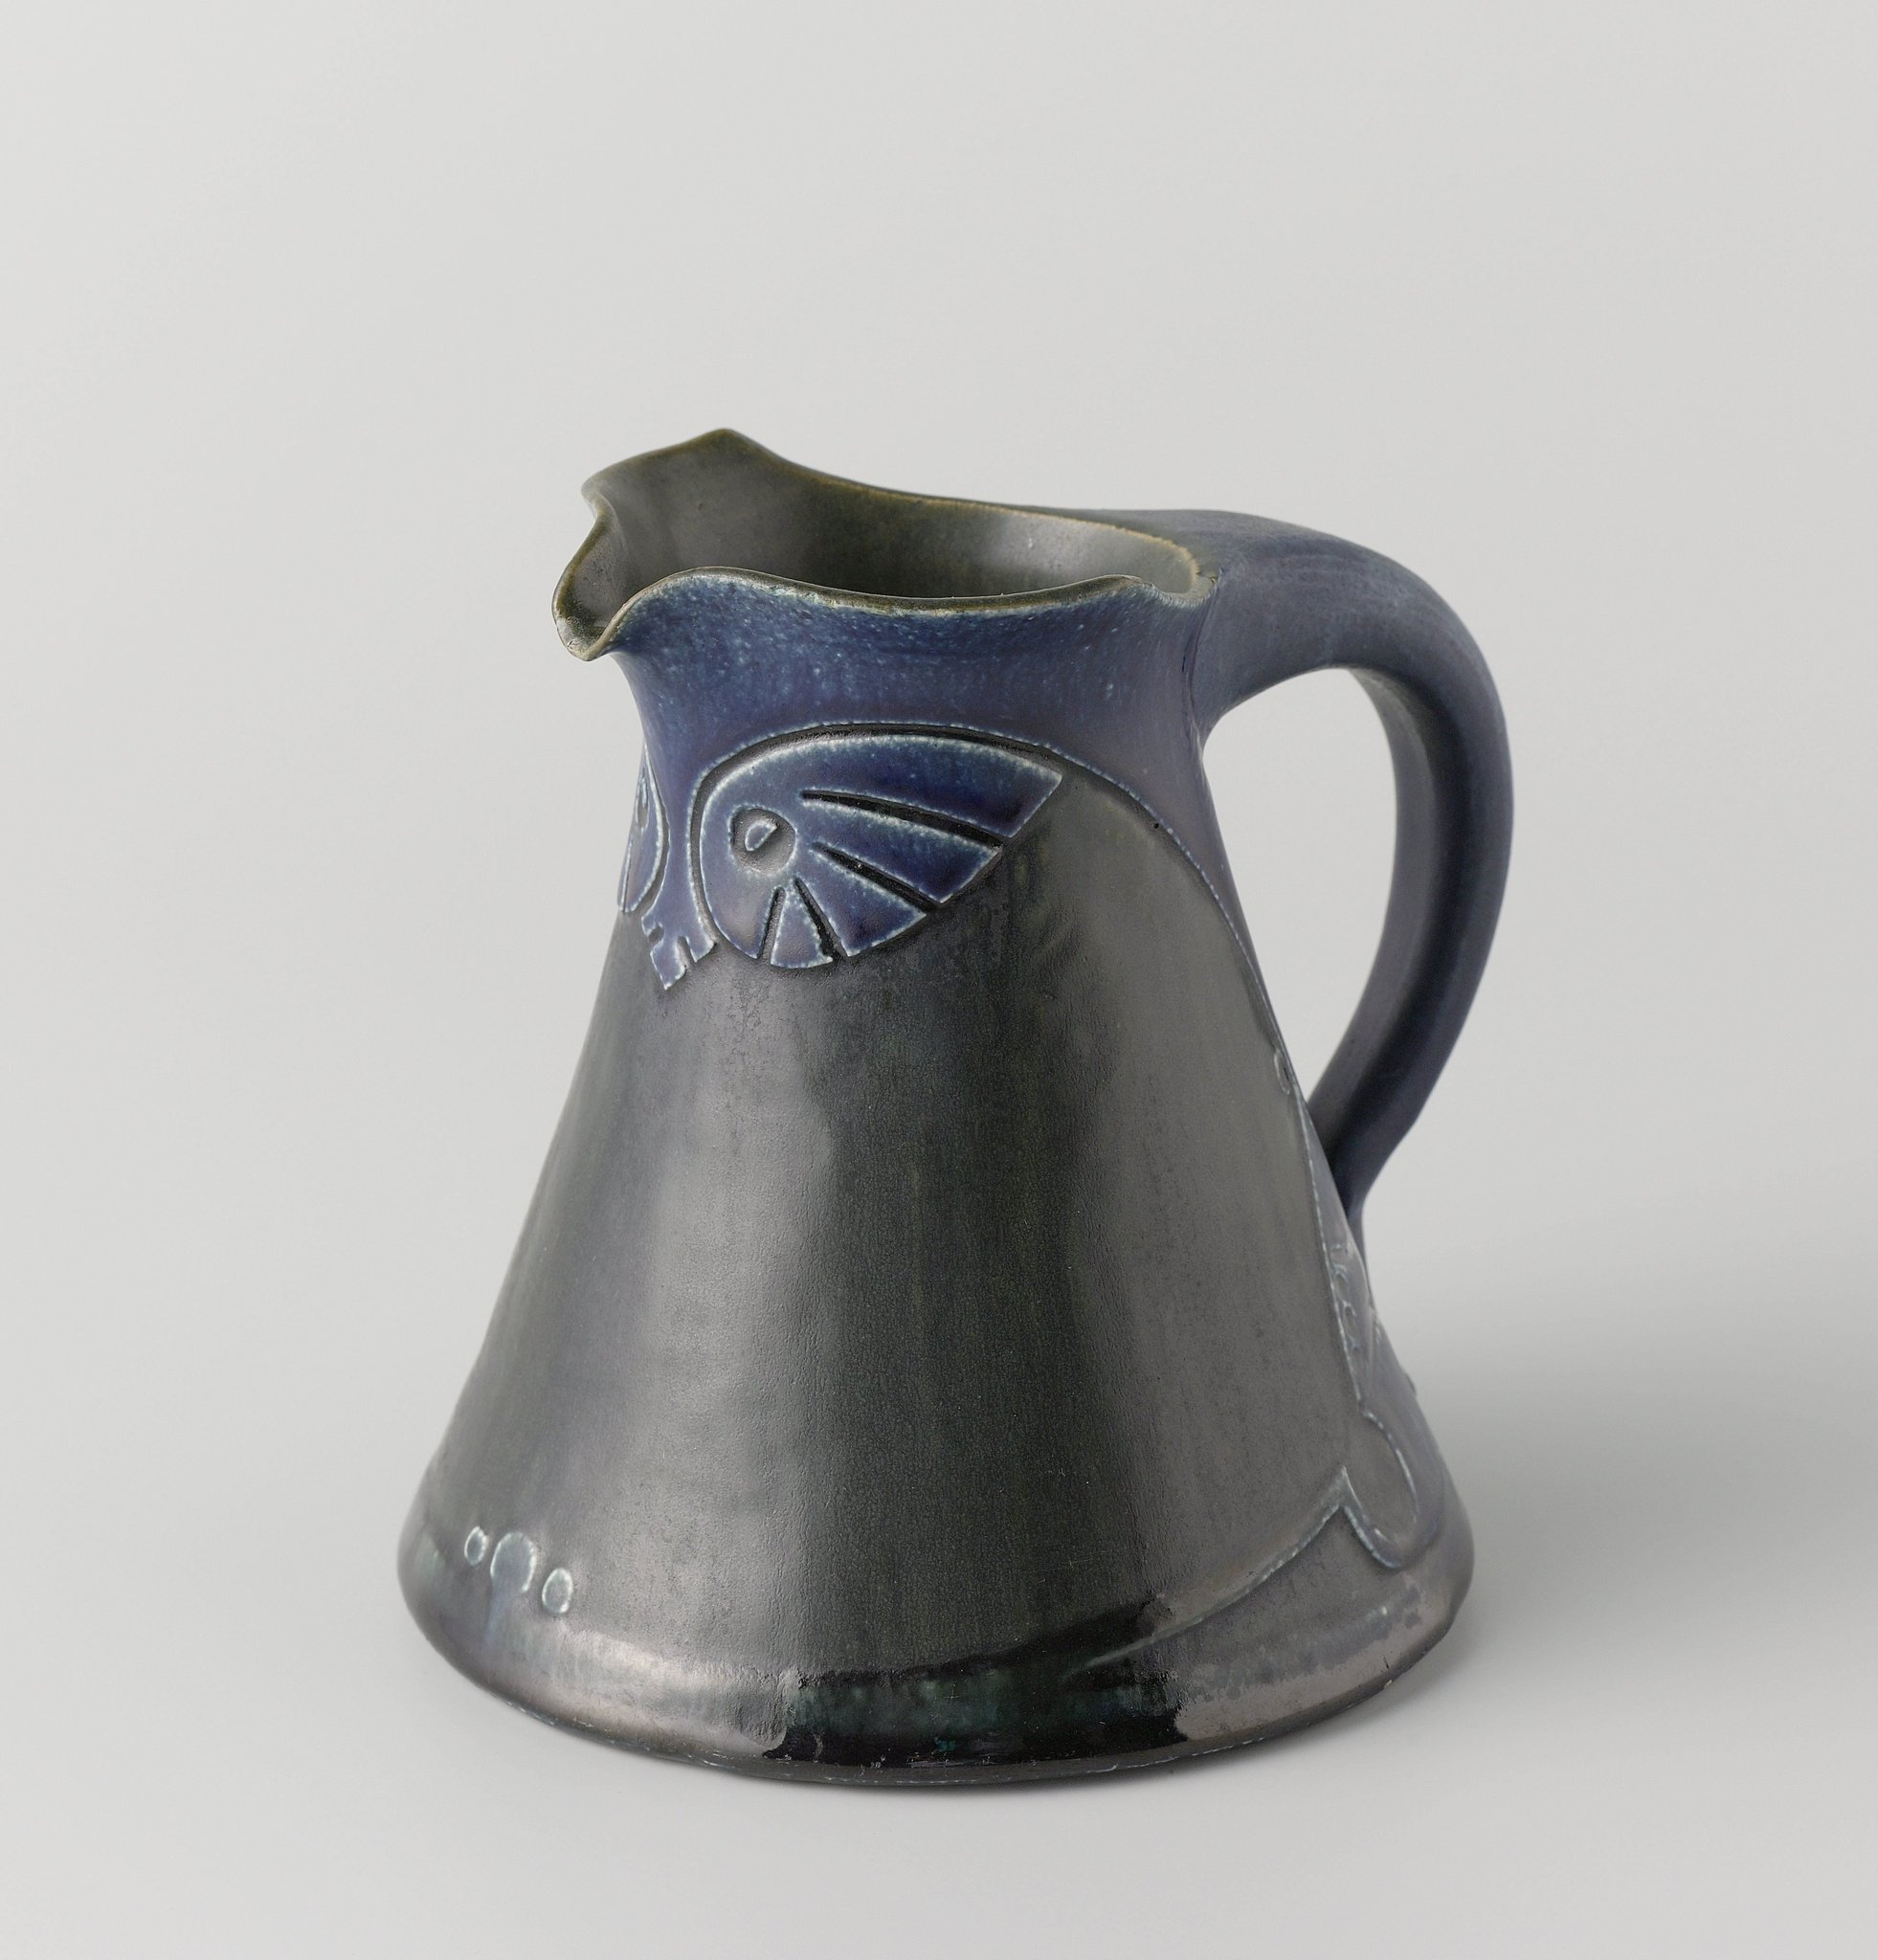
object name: ewer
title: Kan versierd met uil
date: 1907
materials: earthenware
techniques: sgraffito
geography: leiderdorp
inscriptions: mark: ‘Brouwers Aardewerk (ingedrukt, cirkelvormig) rondom monogram en Holland, modelnummer 116 en O 7 (?).’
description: Kan met oor van aardewerk, versierd in tabeer/sgrafitto-techniek met een uil, blauw op zwarte grond.